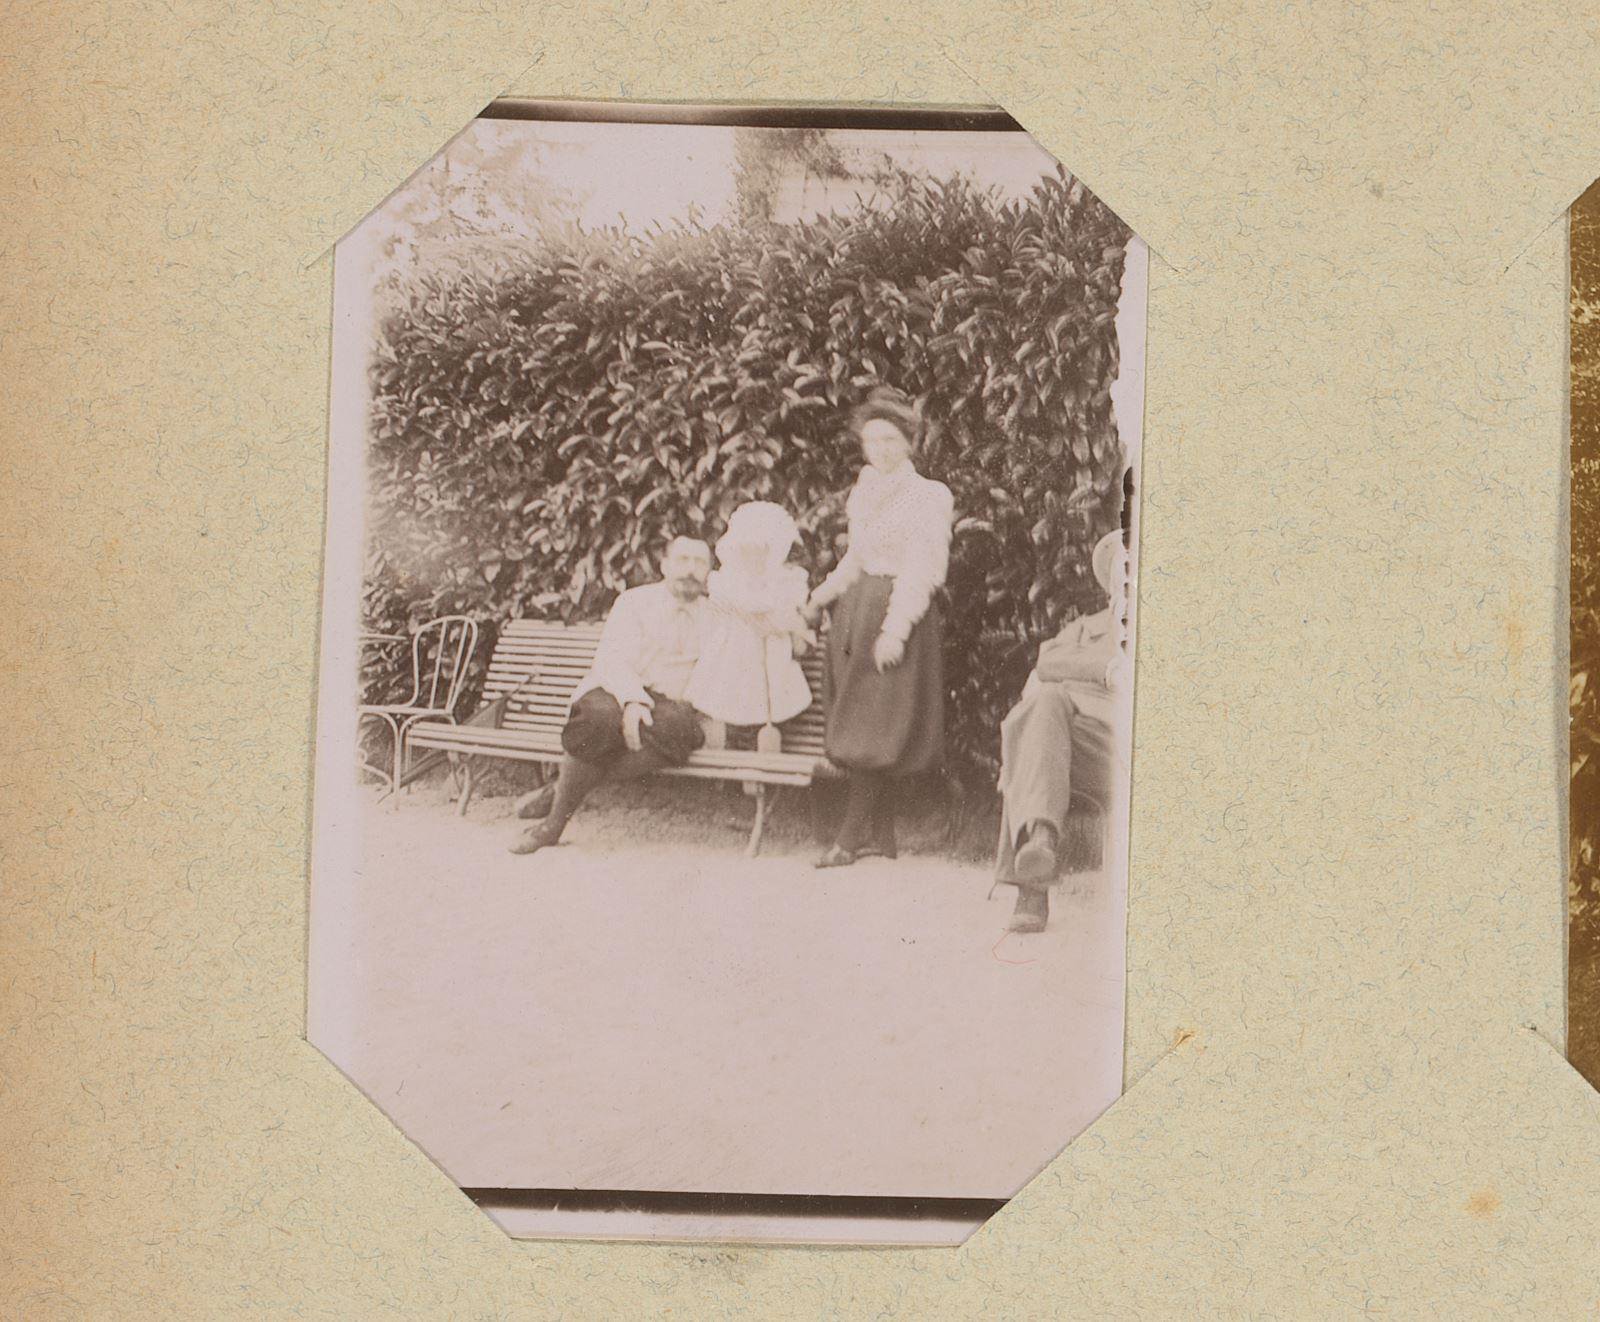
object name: photograph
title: Groepsportret van man, vrouw en kind in een tuin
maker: Anonymous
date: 1895-1900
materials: paper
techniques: gelatin silver print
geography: france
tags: family group, especially parents with their child(ren), garden, anonymous historical person portrayed, france